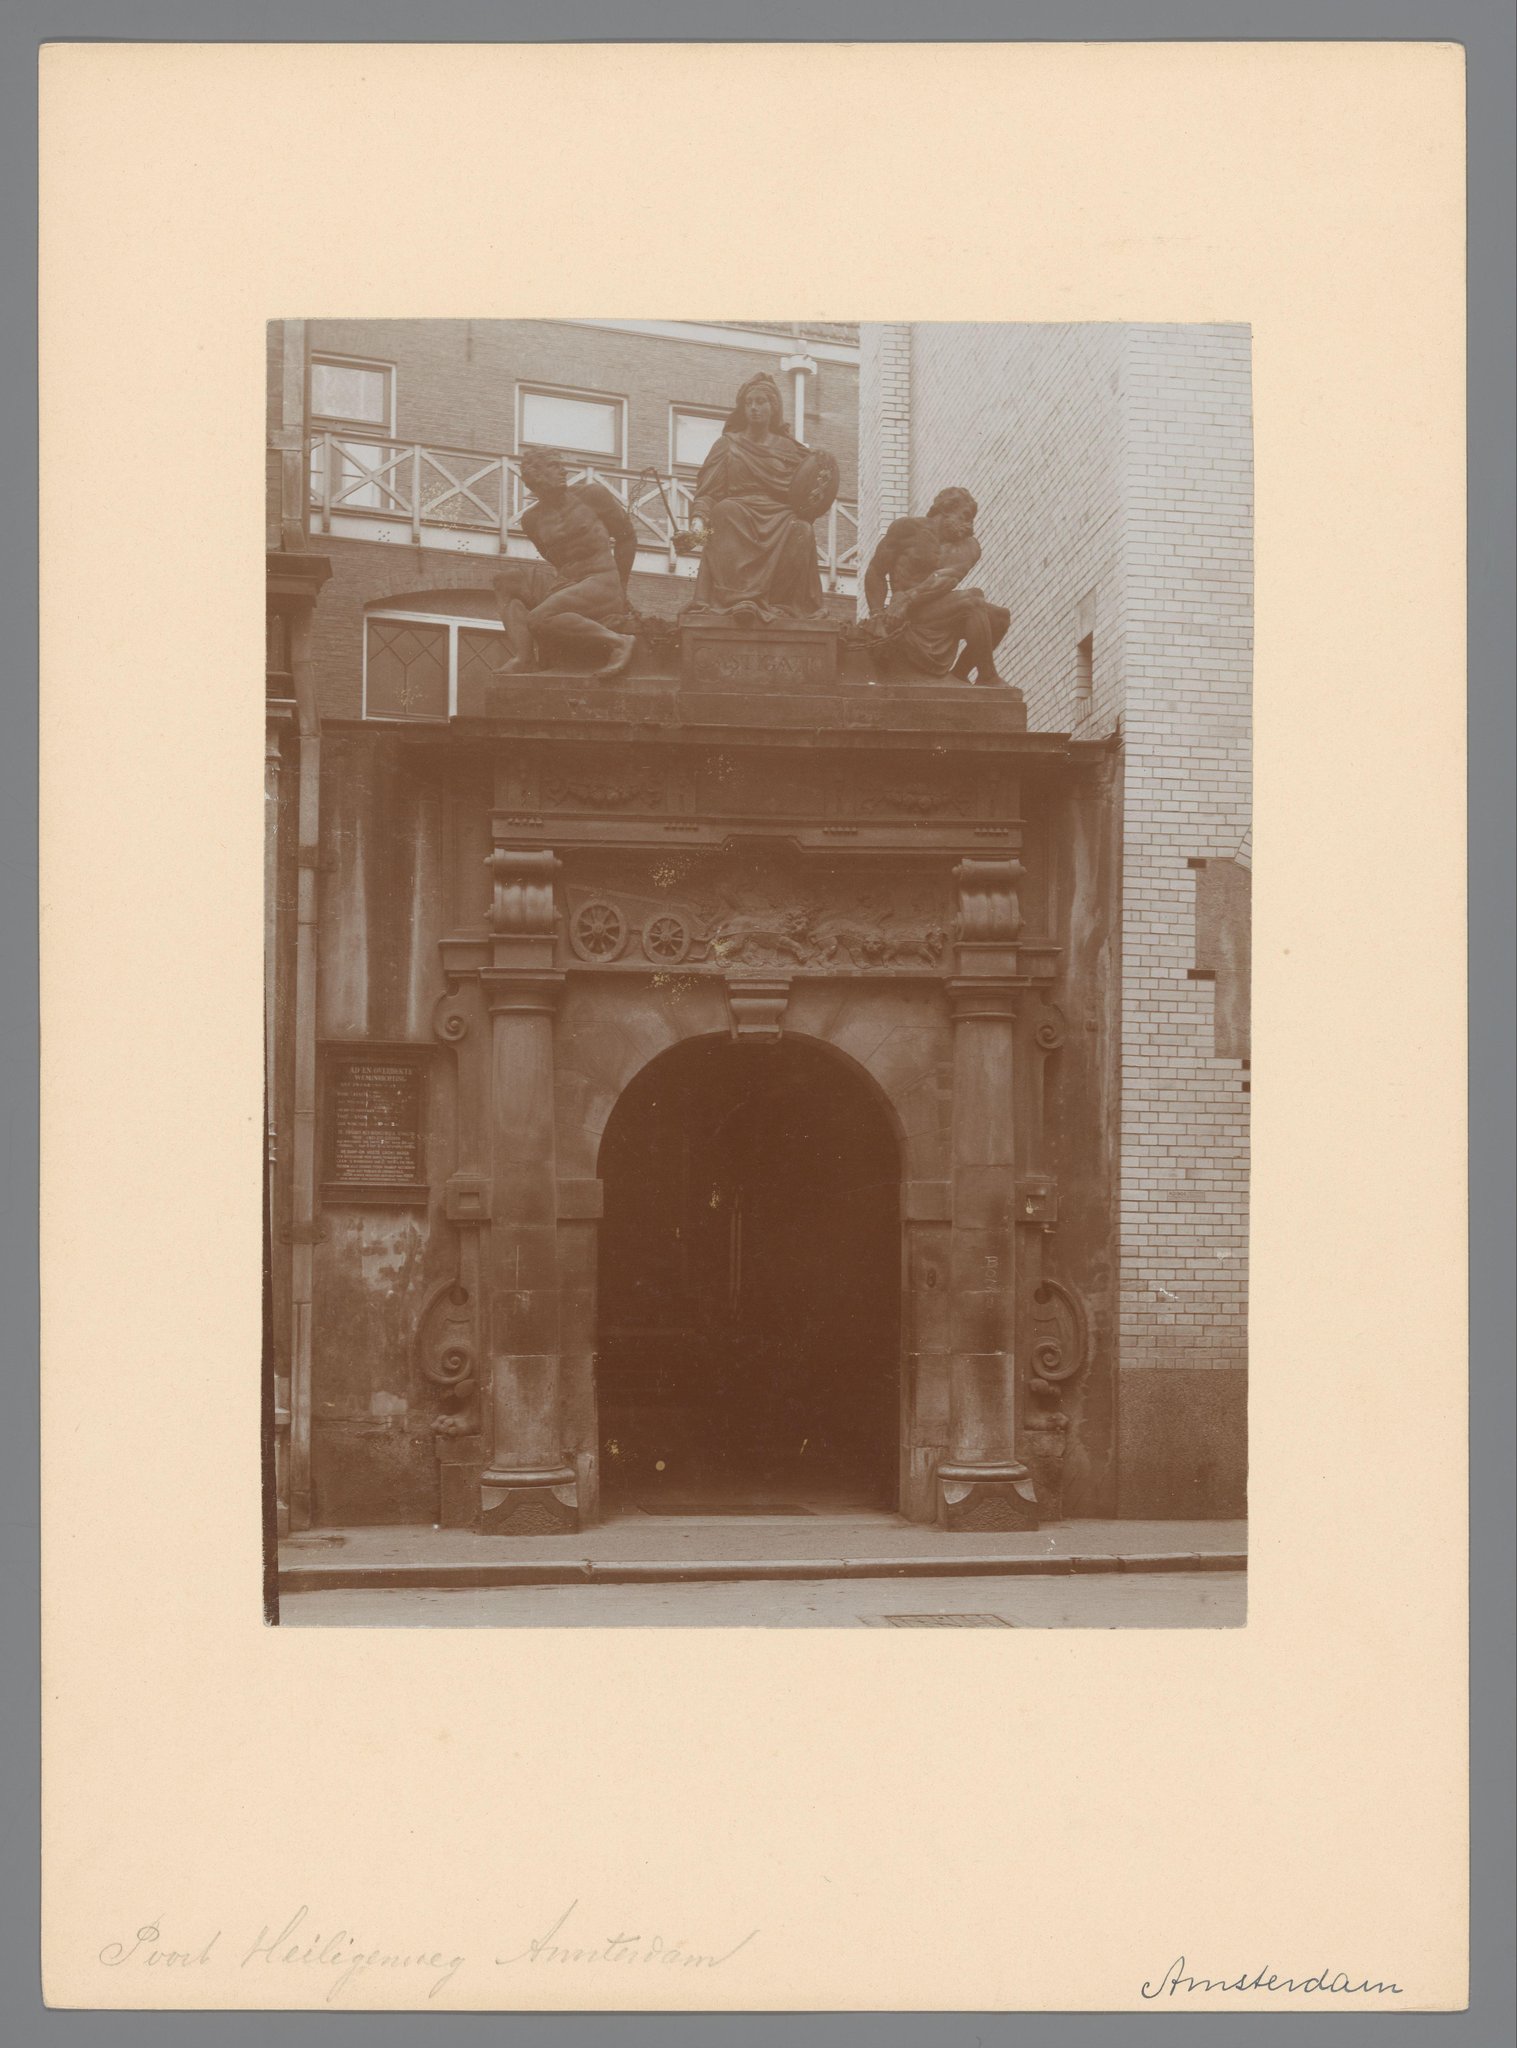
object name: photograph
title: Gezicht op de Rasphuispoort aan de Heiligenweg te Amsterdam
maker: Anonymous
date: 1890-1910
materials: cardboard, photographic support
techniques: collodion silver print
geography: amsterdam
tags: gate, entrance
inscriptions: annotation: ‘Poort Heiligenweg Amsterdam/ Amsterdam’, name: ‘Margaretha van Parma’